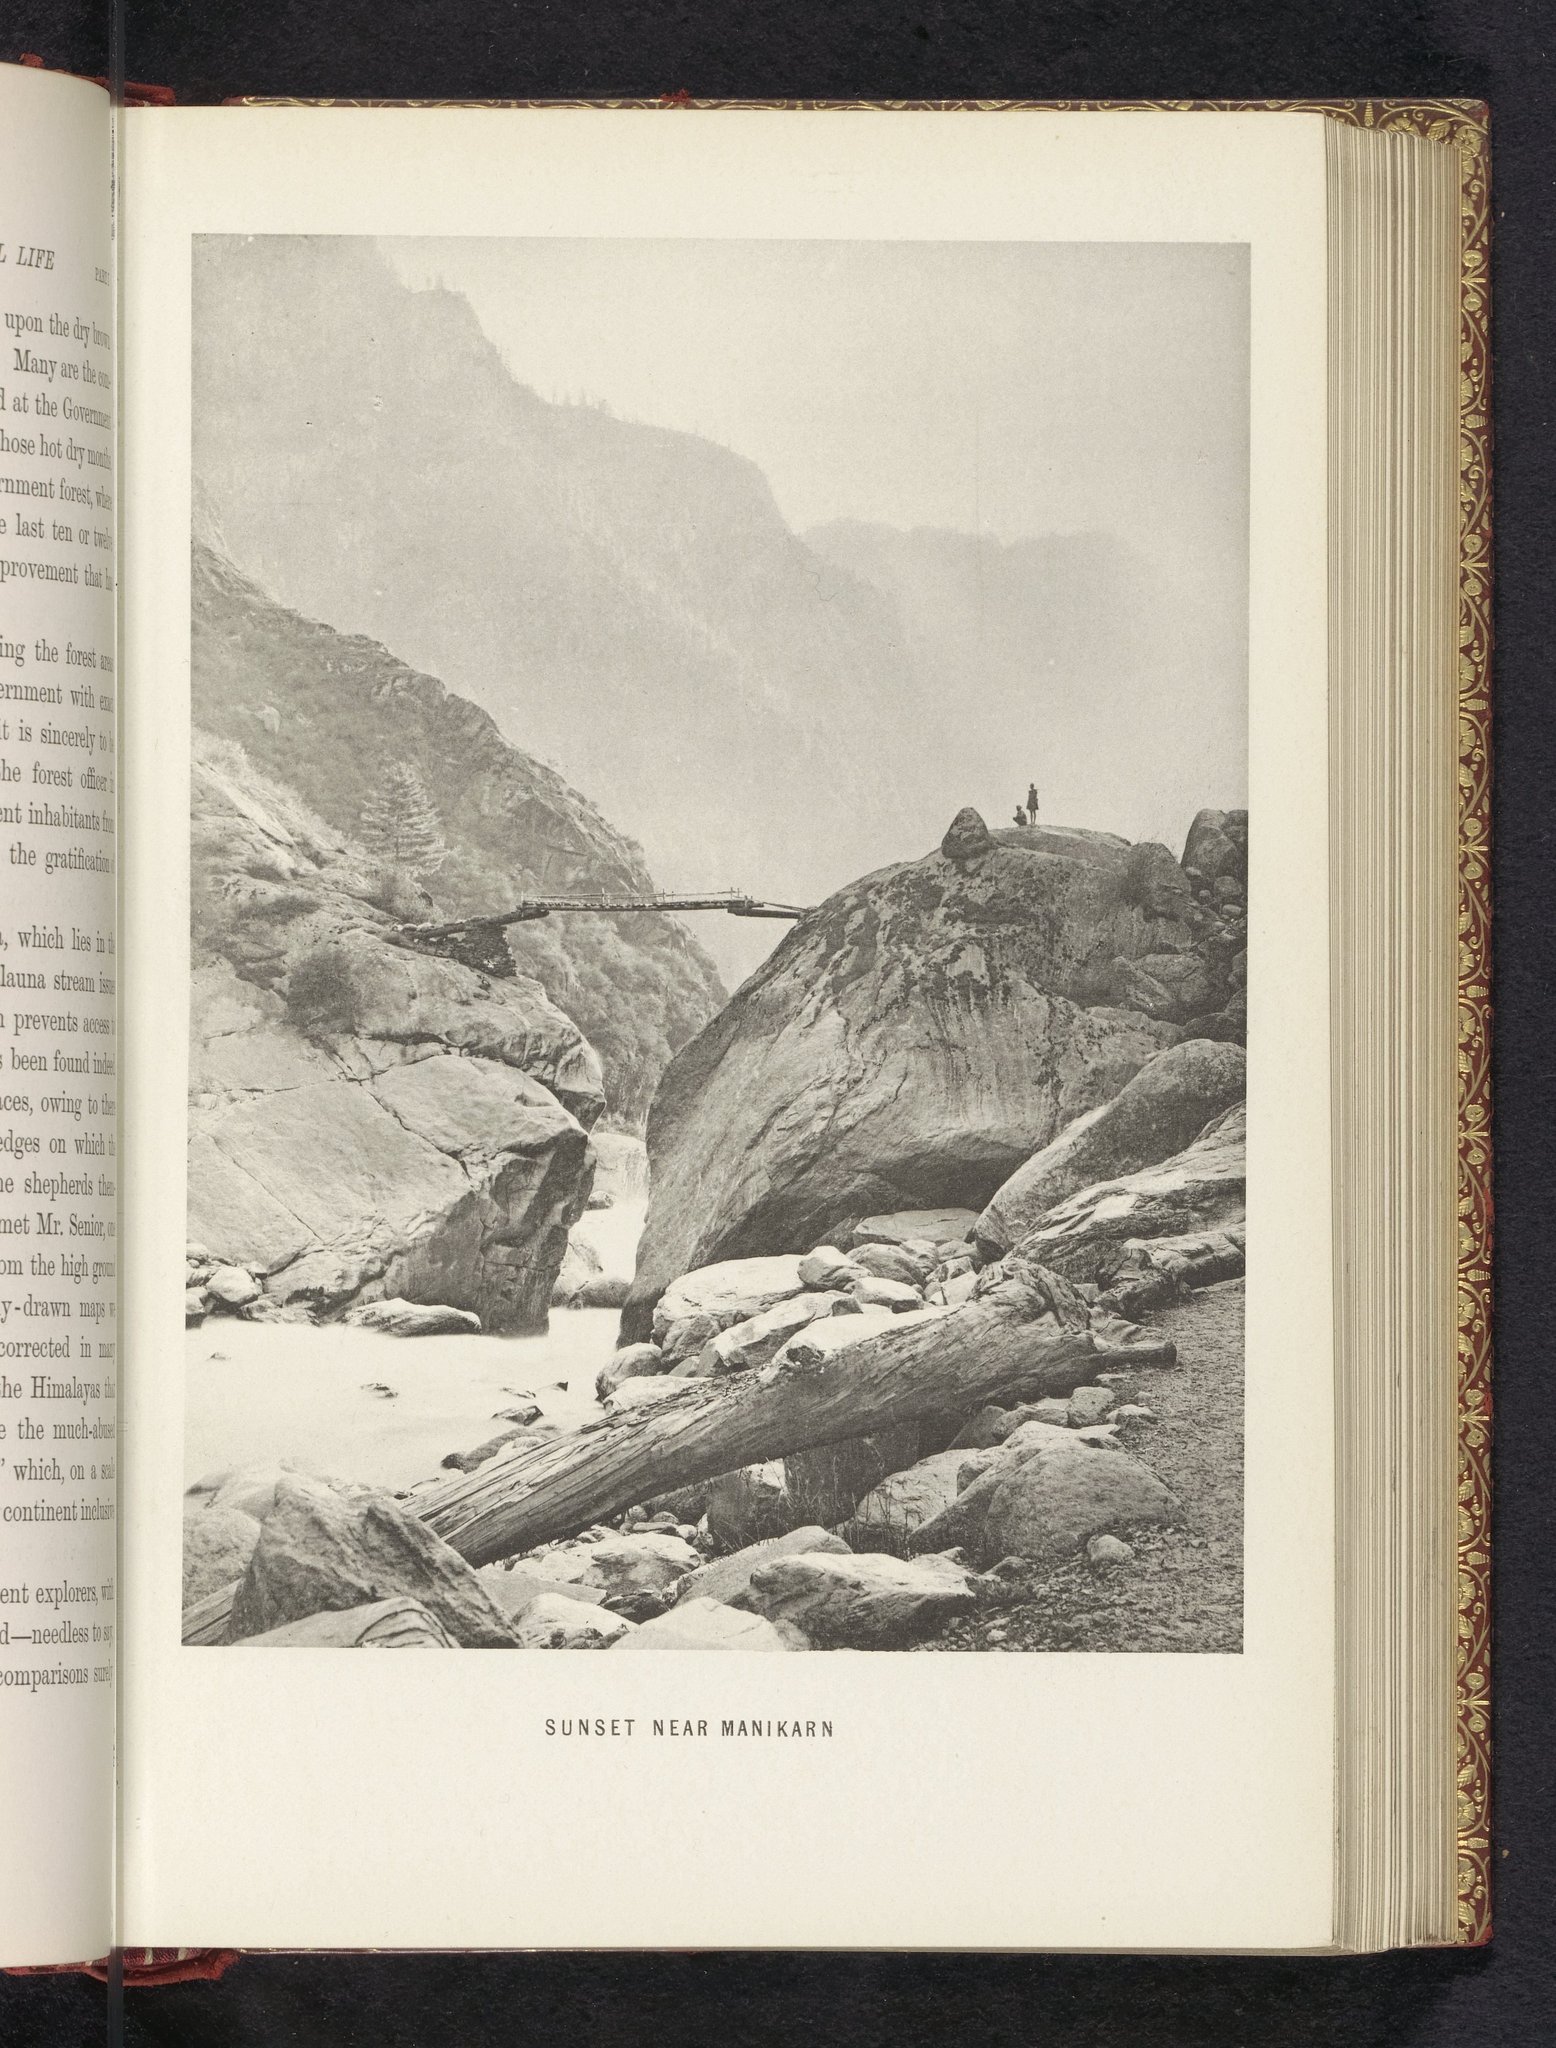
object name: photomechanical print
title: Bridge over the Parvati valley near Manikaran, Himachal Pradesh, India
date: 1890-1895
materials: paper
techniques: photograph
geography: parvati valley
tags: river, landscape with bridge, viaduct or aqueduct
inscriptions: caption: ‘SUNSET NEAR MANIKARN’